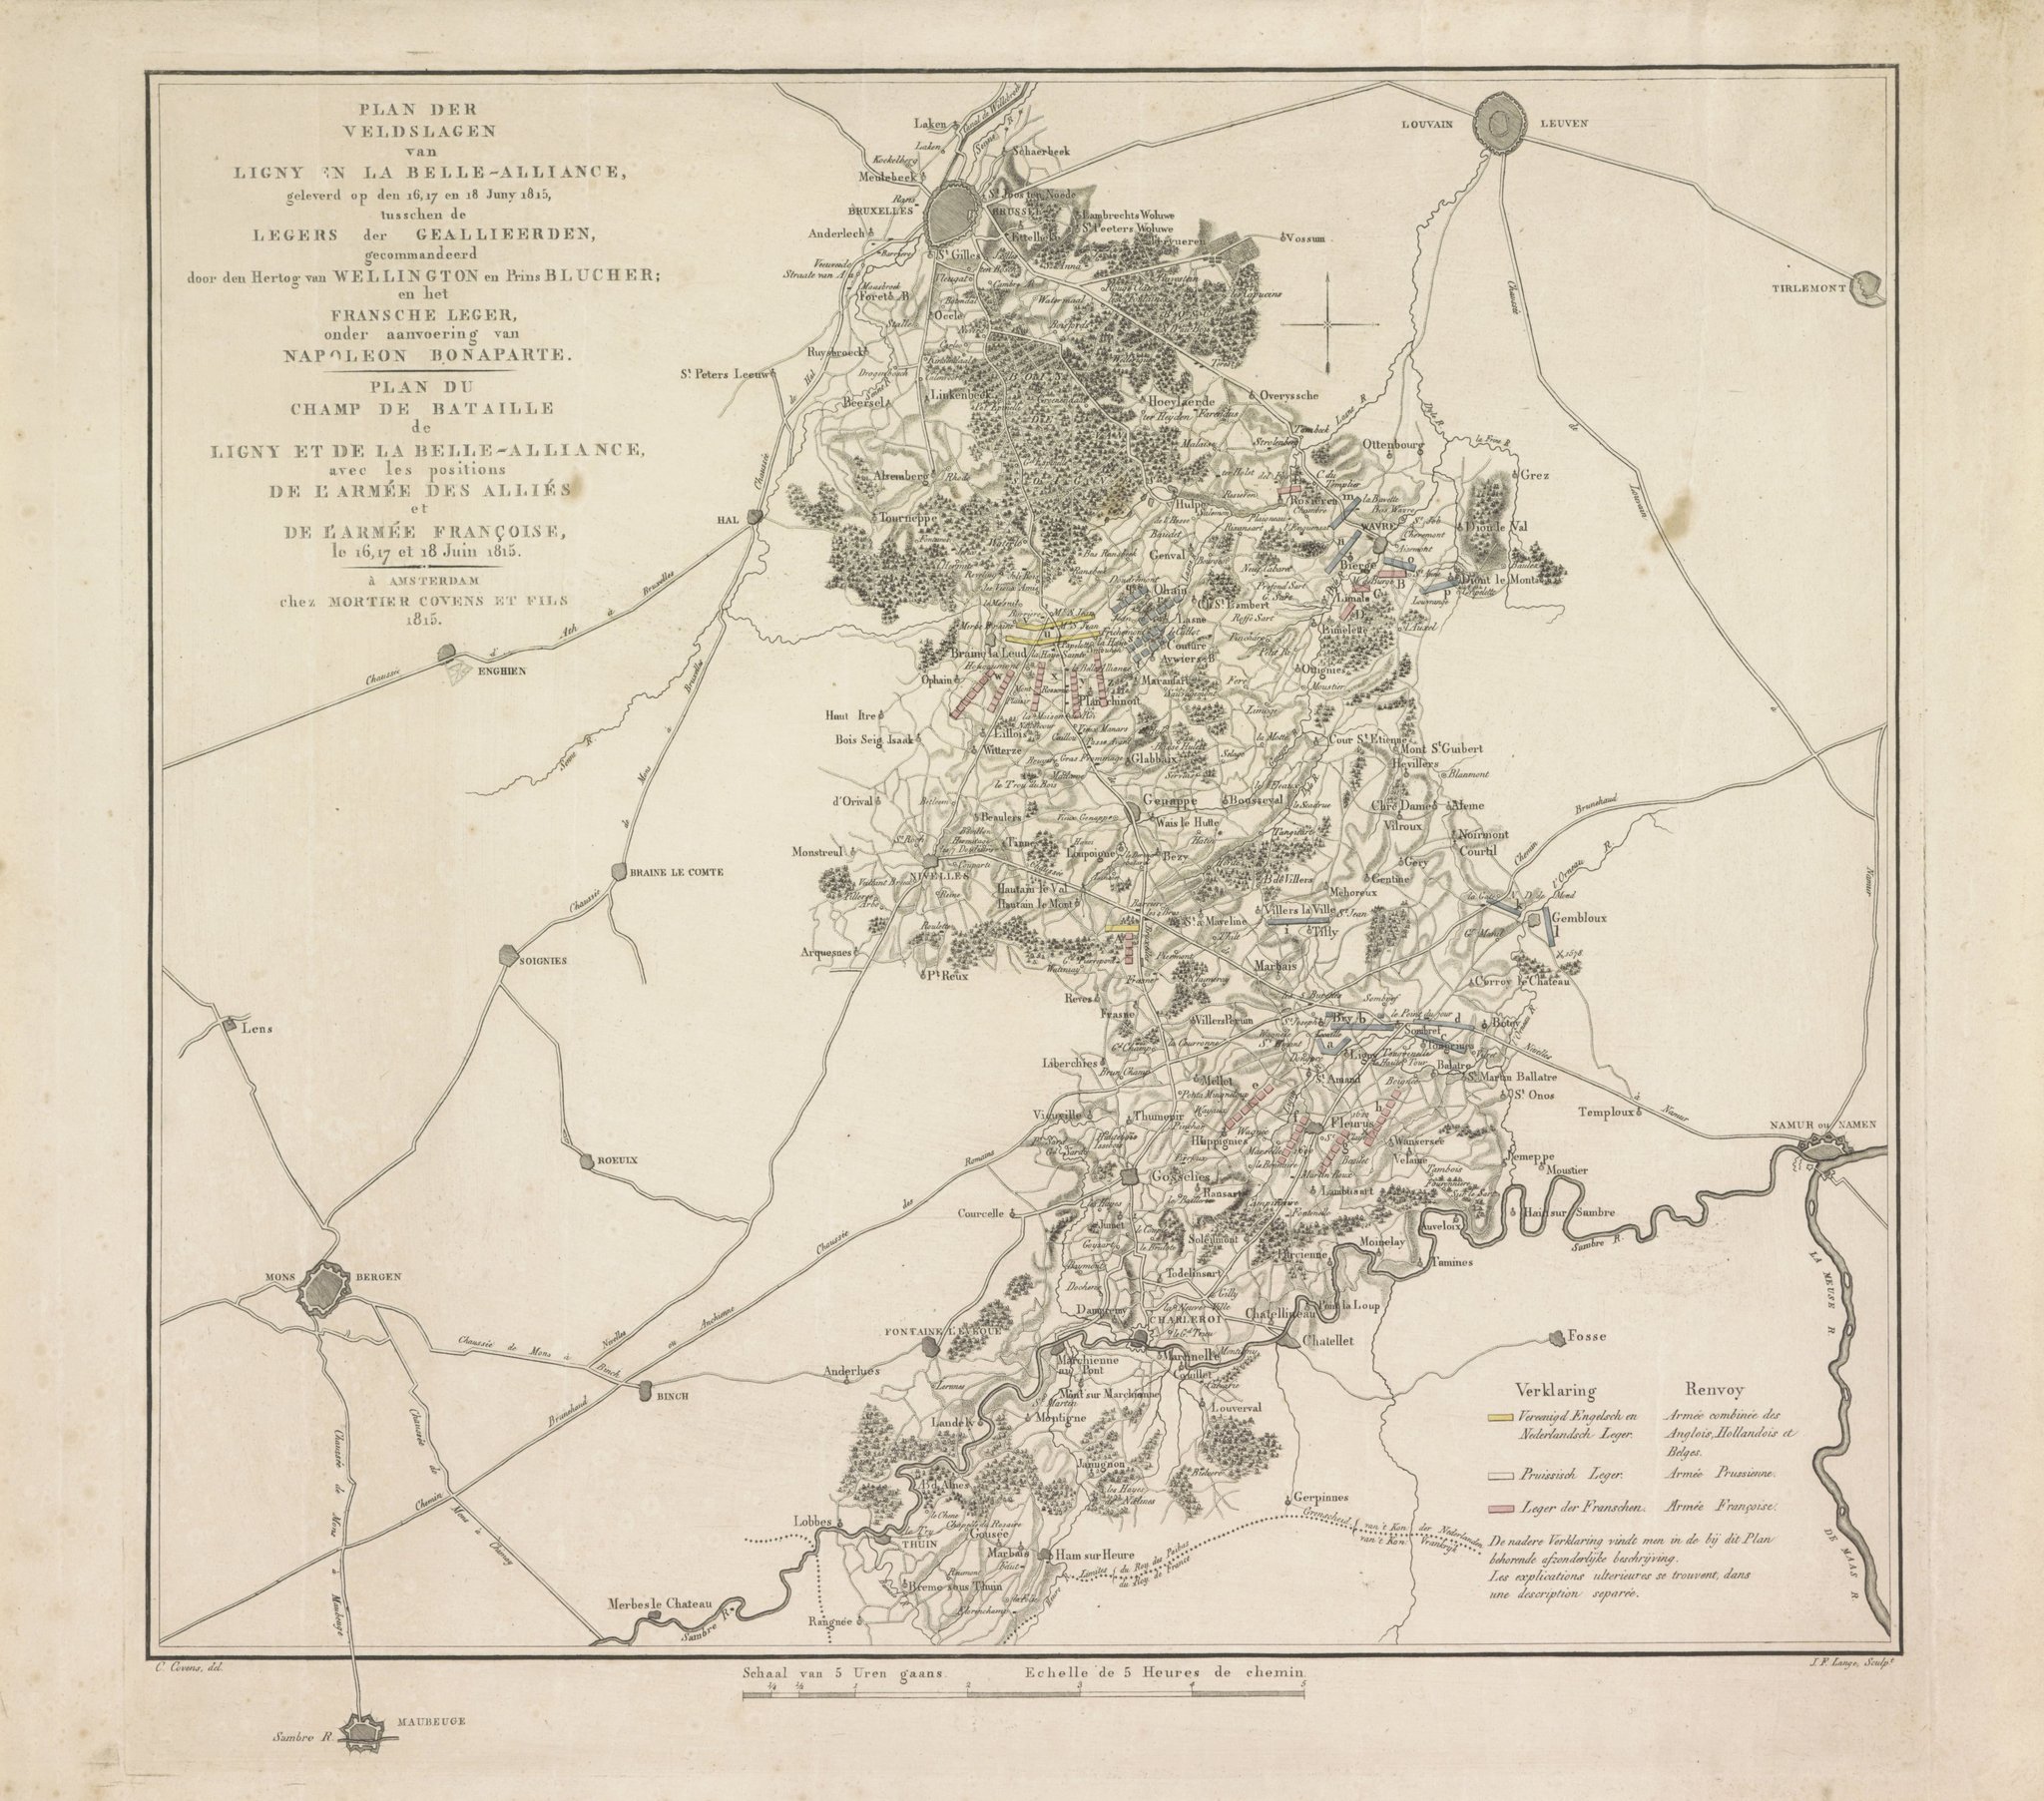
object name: map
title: Plan van de Slag bij Waterloo, 1815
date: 1815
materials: paper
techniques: etching, hand coloring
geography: netherlands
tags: maps of separate countries or regions, battle arrays, belgium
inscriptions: collector's mark: Lugt 2228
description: Kaart van de streek tussen Brussel en Charleroi waar tussen 16-18 juni 1815 bij Ligny, Wavre, Quatre-Bras en Waterloo veldslagen zijn uitgevochten tussen de legers van de Geallieerden en het Franse leger onder Napoleon. Met titels en legenda in Nederlands en Frans. De verschillende legers met kleuren aangeduid.